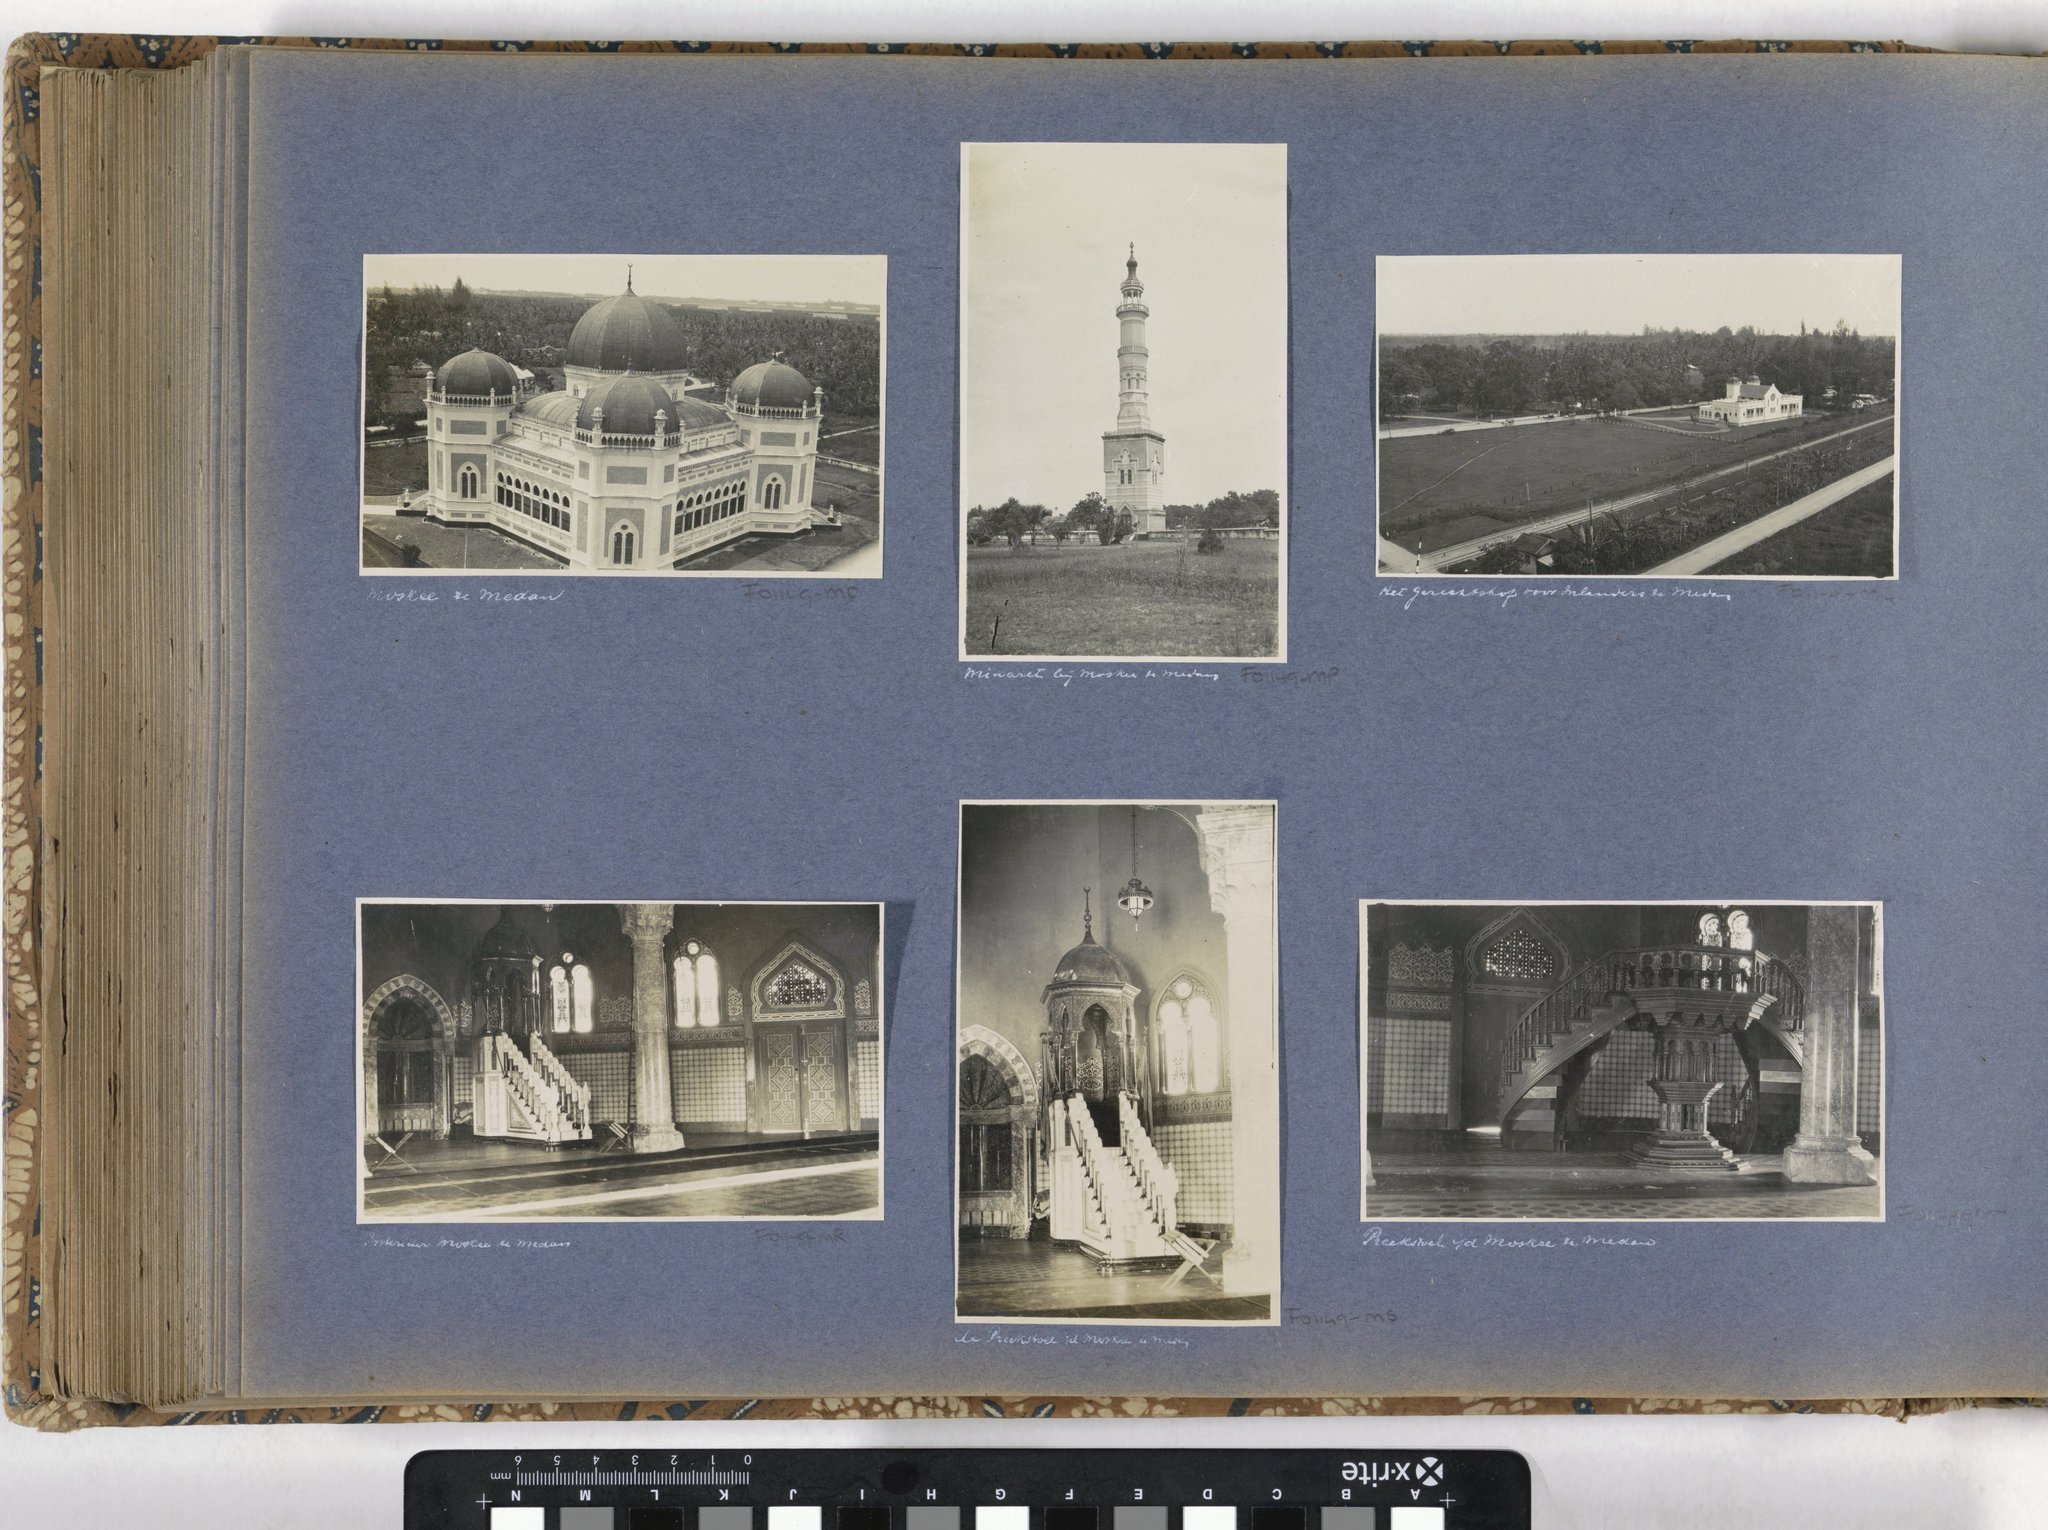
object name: album leaf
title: Interieur van de Grote Moskee (Masjid Raya Al Mashun) in Medan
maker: Anonymous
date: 1900-1920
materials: paper, photographic support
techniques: gelatin silver print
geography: medan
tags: temple, shrine ~ islam, mohammedanism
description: Onderdeel van reisalbum met foto's van bedrijvigheid en bezienswaardigheden op Sumatra en Java en van de reis naar en van Nederlands-Indië.